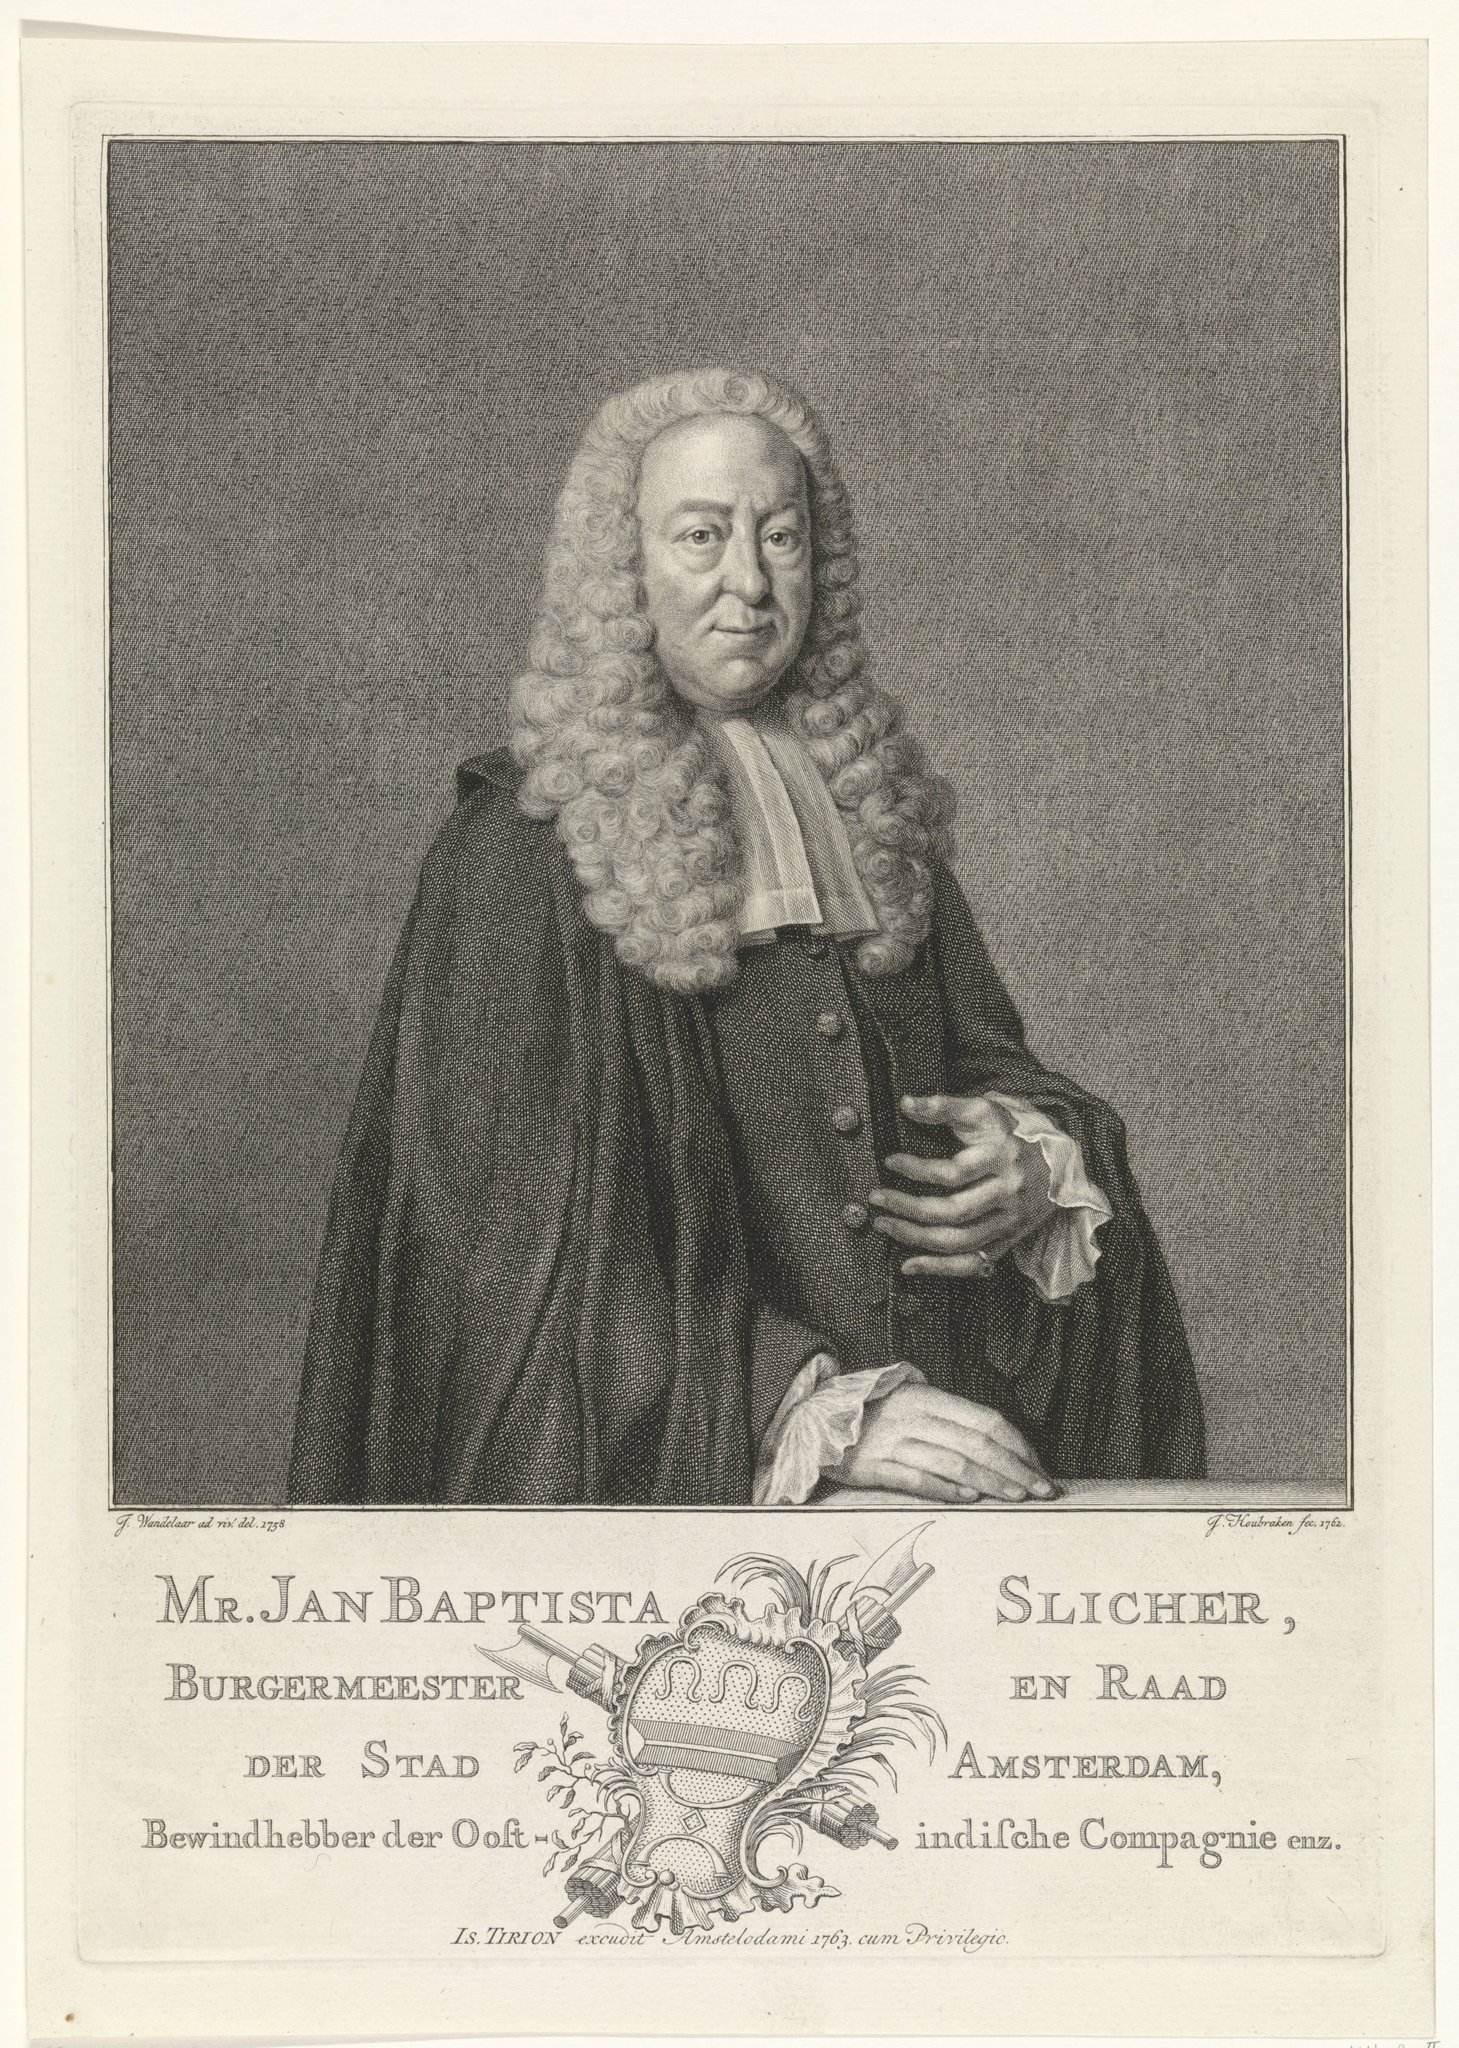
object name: print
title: Mr. Jan Baptista Slicher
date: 1763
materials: paper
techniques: engraving, etching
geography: amsterdam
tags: adult man, historical persons, armorial bearing, heraldry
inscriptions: collector's mark: Lugt 240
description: Portret ten halven lijve naar rechts van Jan Baptista Slicher. Onder het portret zijn naam en gegevens in vier regels in het Nederlands en zijn familiewapen met fasces.